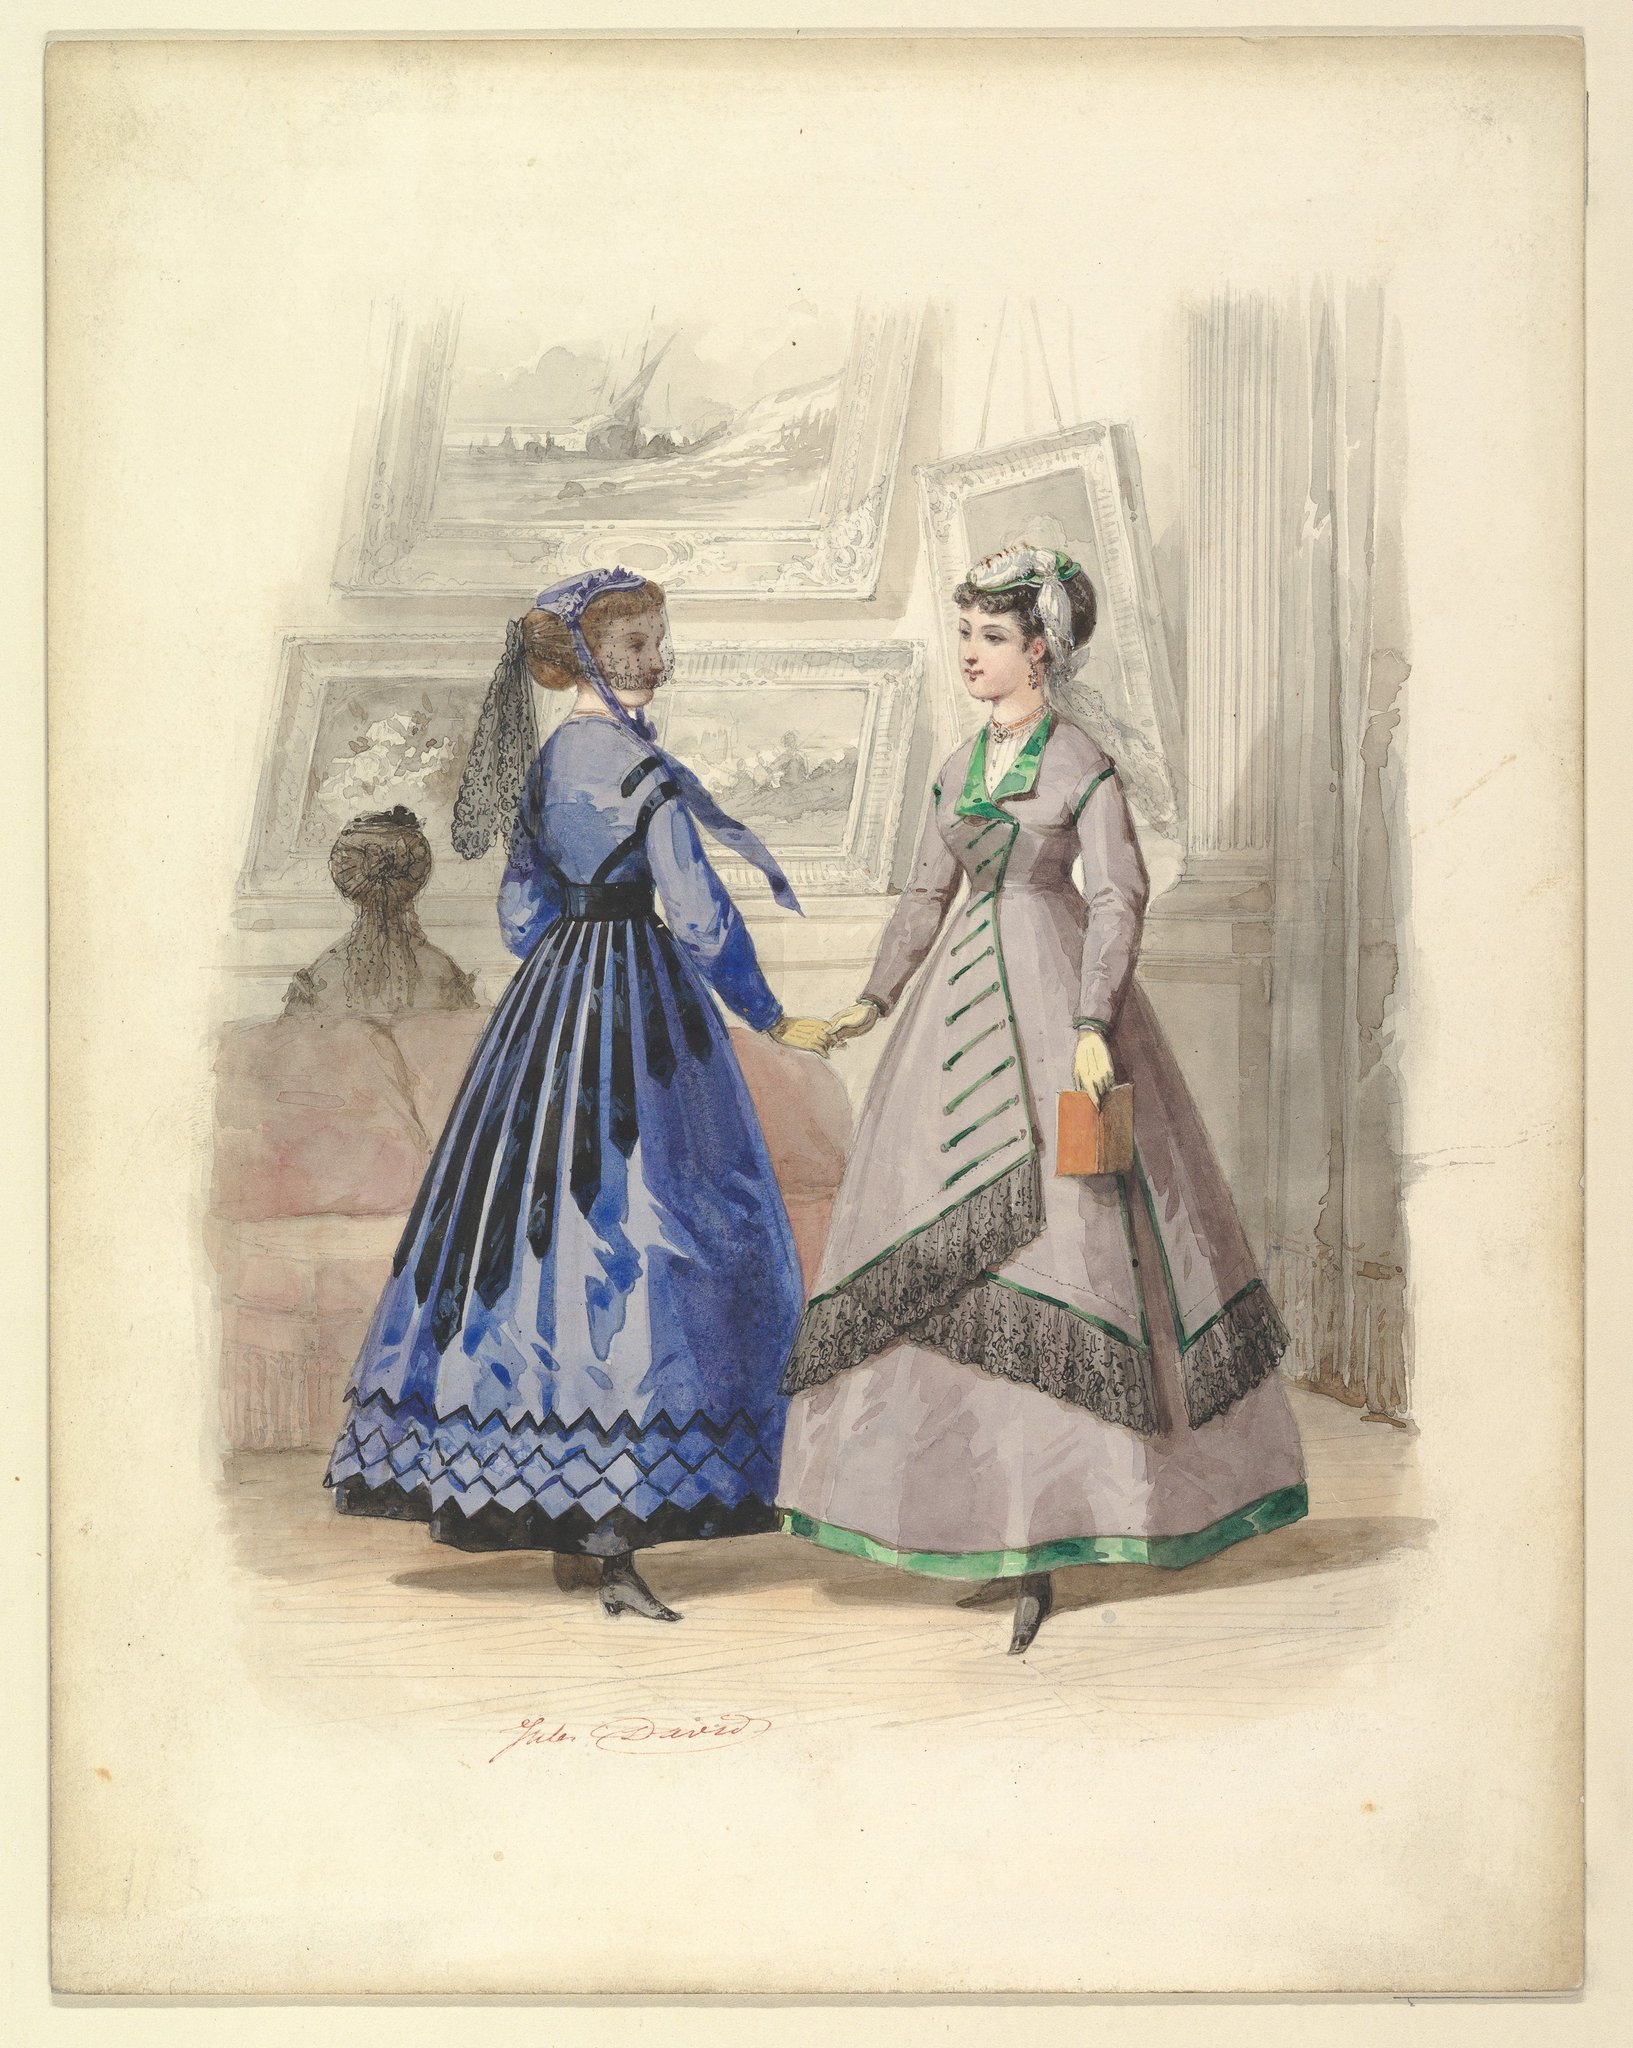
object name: drawing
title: Two Women in an Art Gallery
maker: jules david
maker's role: artist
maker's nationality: french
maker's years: 1808-1892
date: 1868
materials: watercolor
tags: women